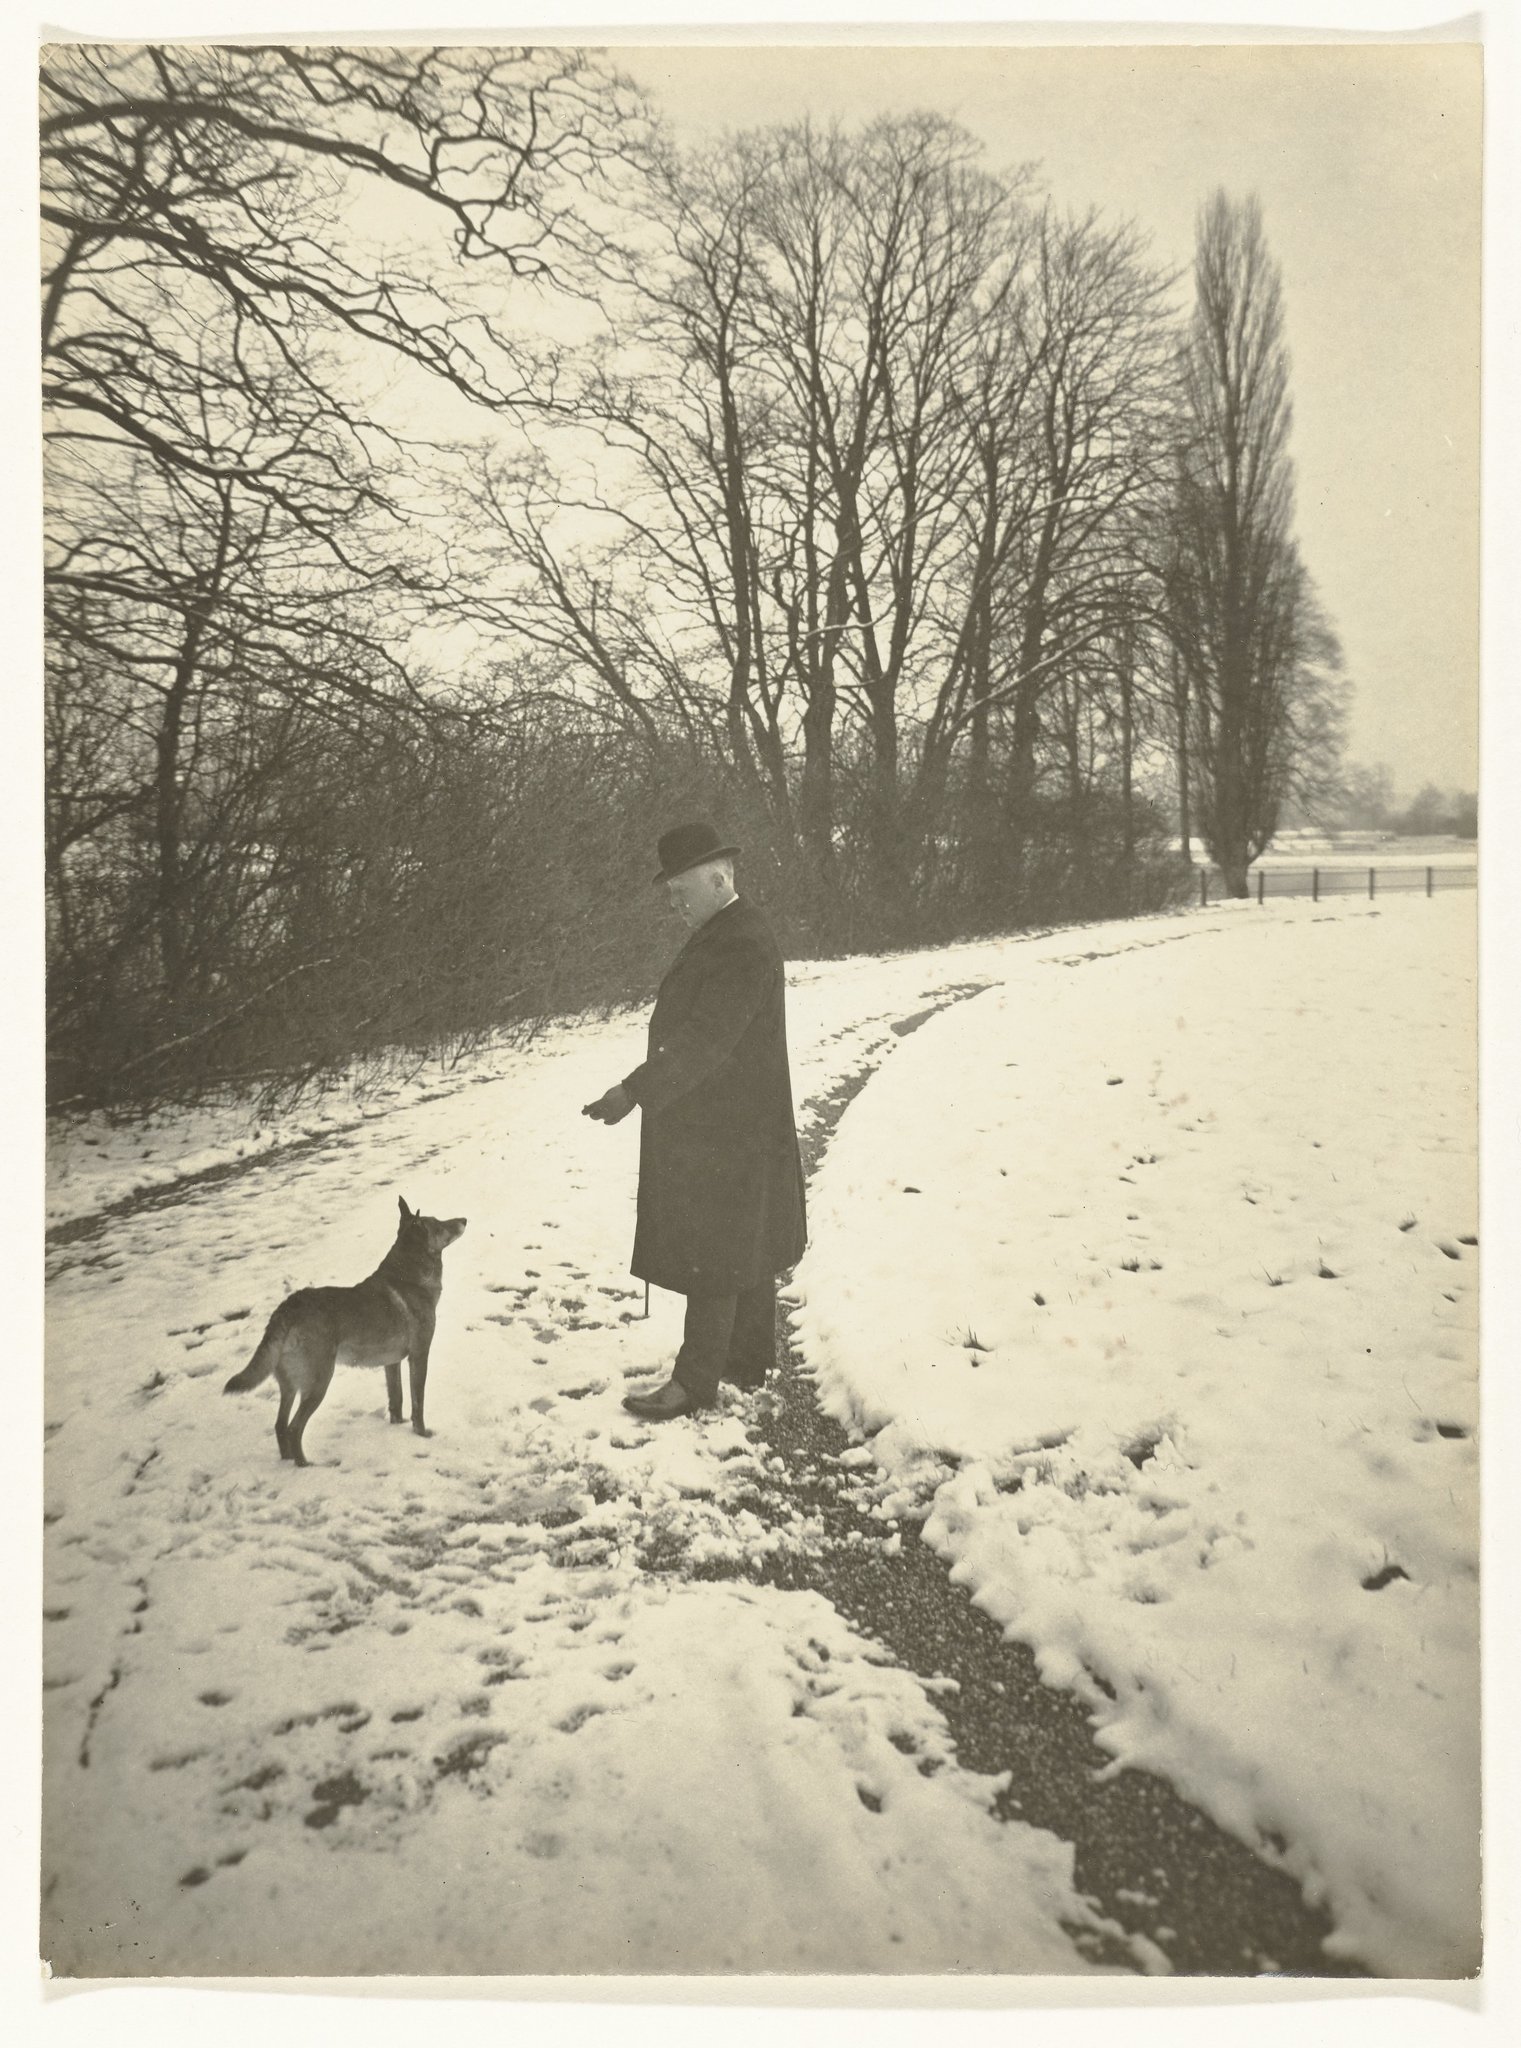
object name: photograph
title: Op het Landgoed De Poll te Gietelo Gemeente Voorst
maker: richard tepe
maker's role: fotograaf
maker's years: 1864-1952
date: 1900-1930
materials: paper, photographic support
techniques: gelatin silver print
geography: netherlands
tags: dog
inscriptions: annotation: ‘Op het Landgoed / De Poll / te Gietelo / Gemeente Voorst (G)’, signature: ‘foto / R Tepe’